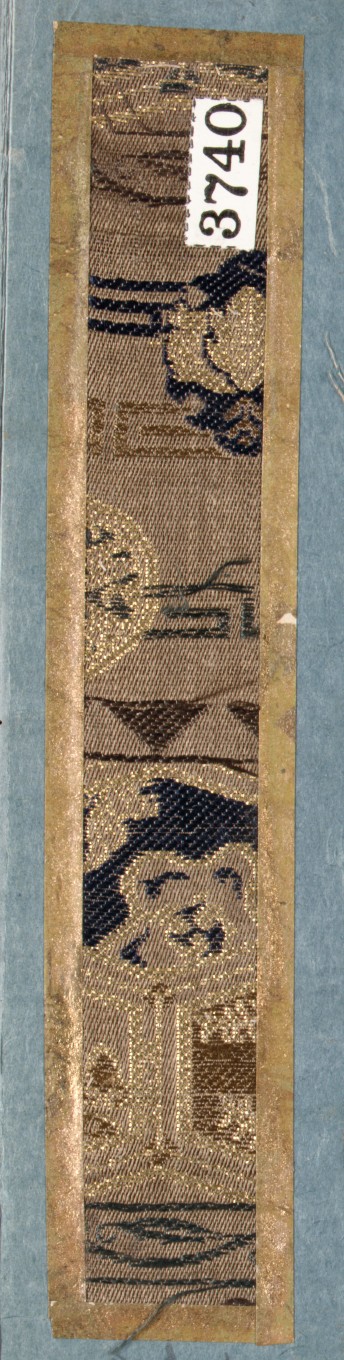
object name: sample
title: Textile Sample from Sample Book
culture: japanese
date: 1801-1900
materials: silk